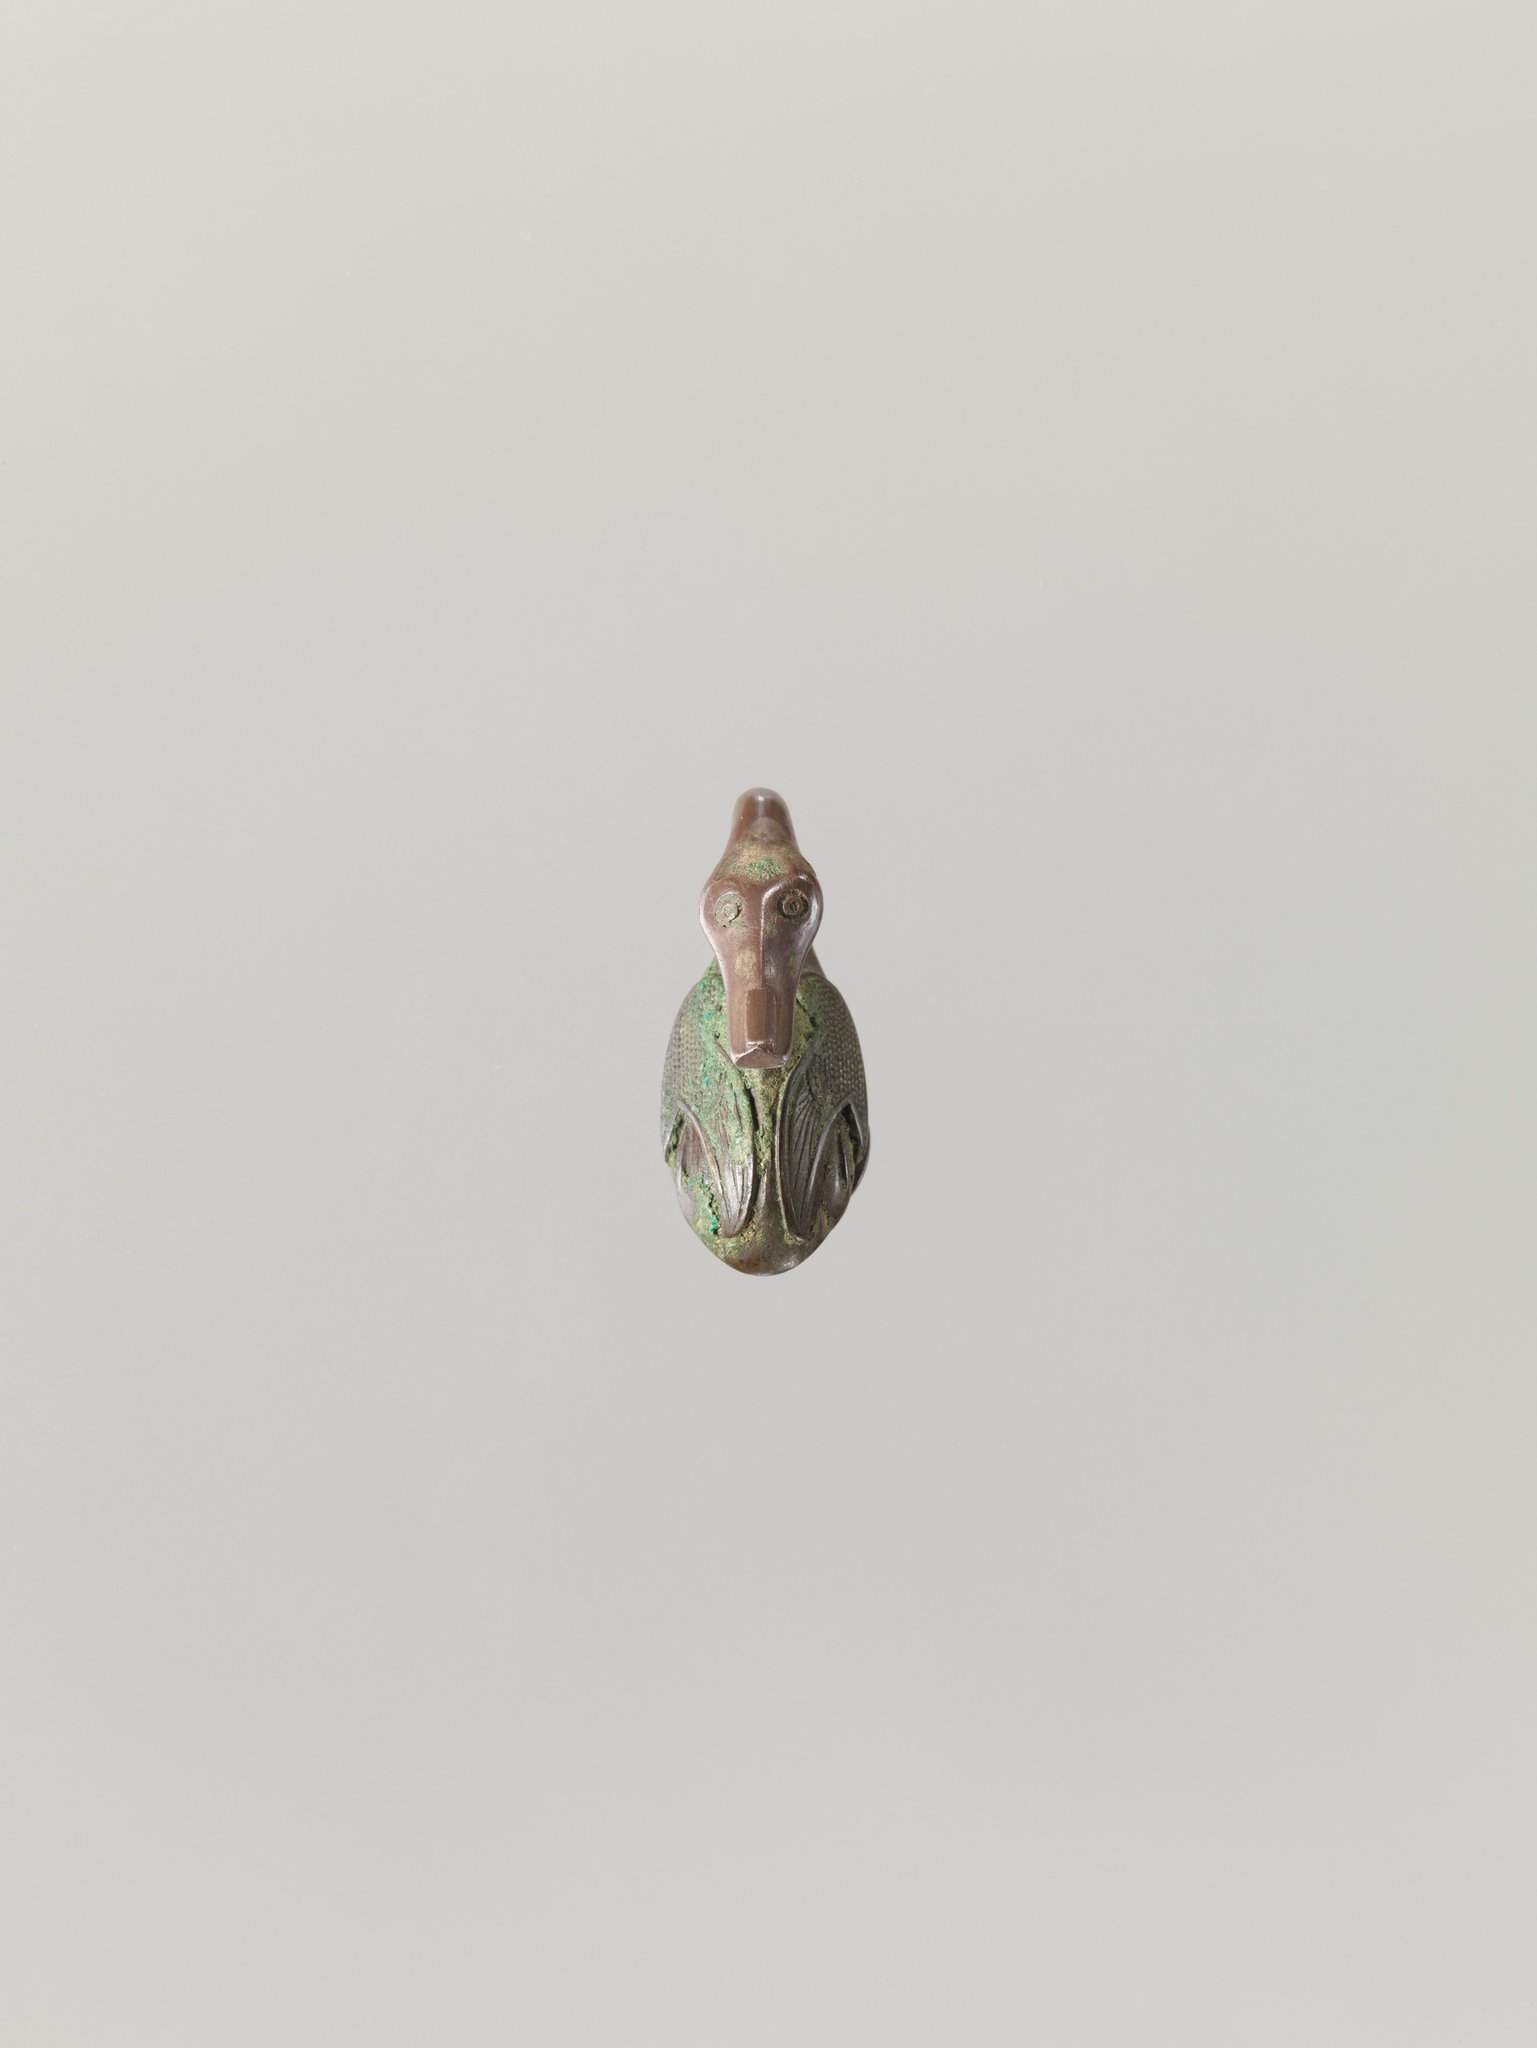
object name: belt hook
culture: chinese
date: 960-1279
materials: silver